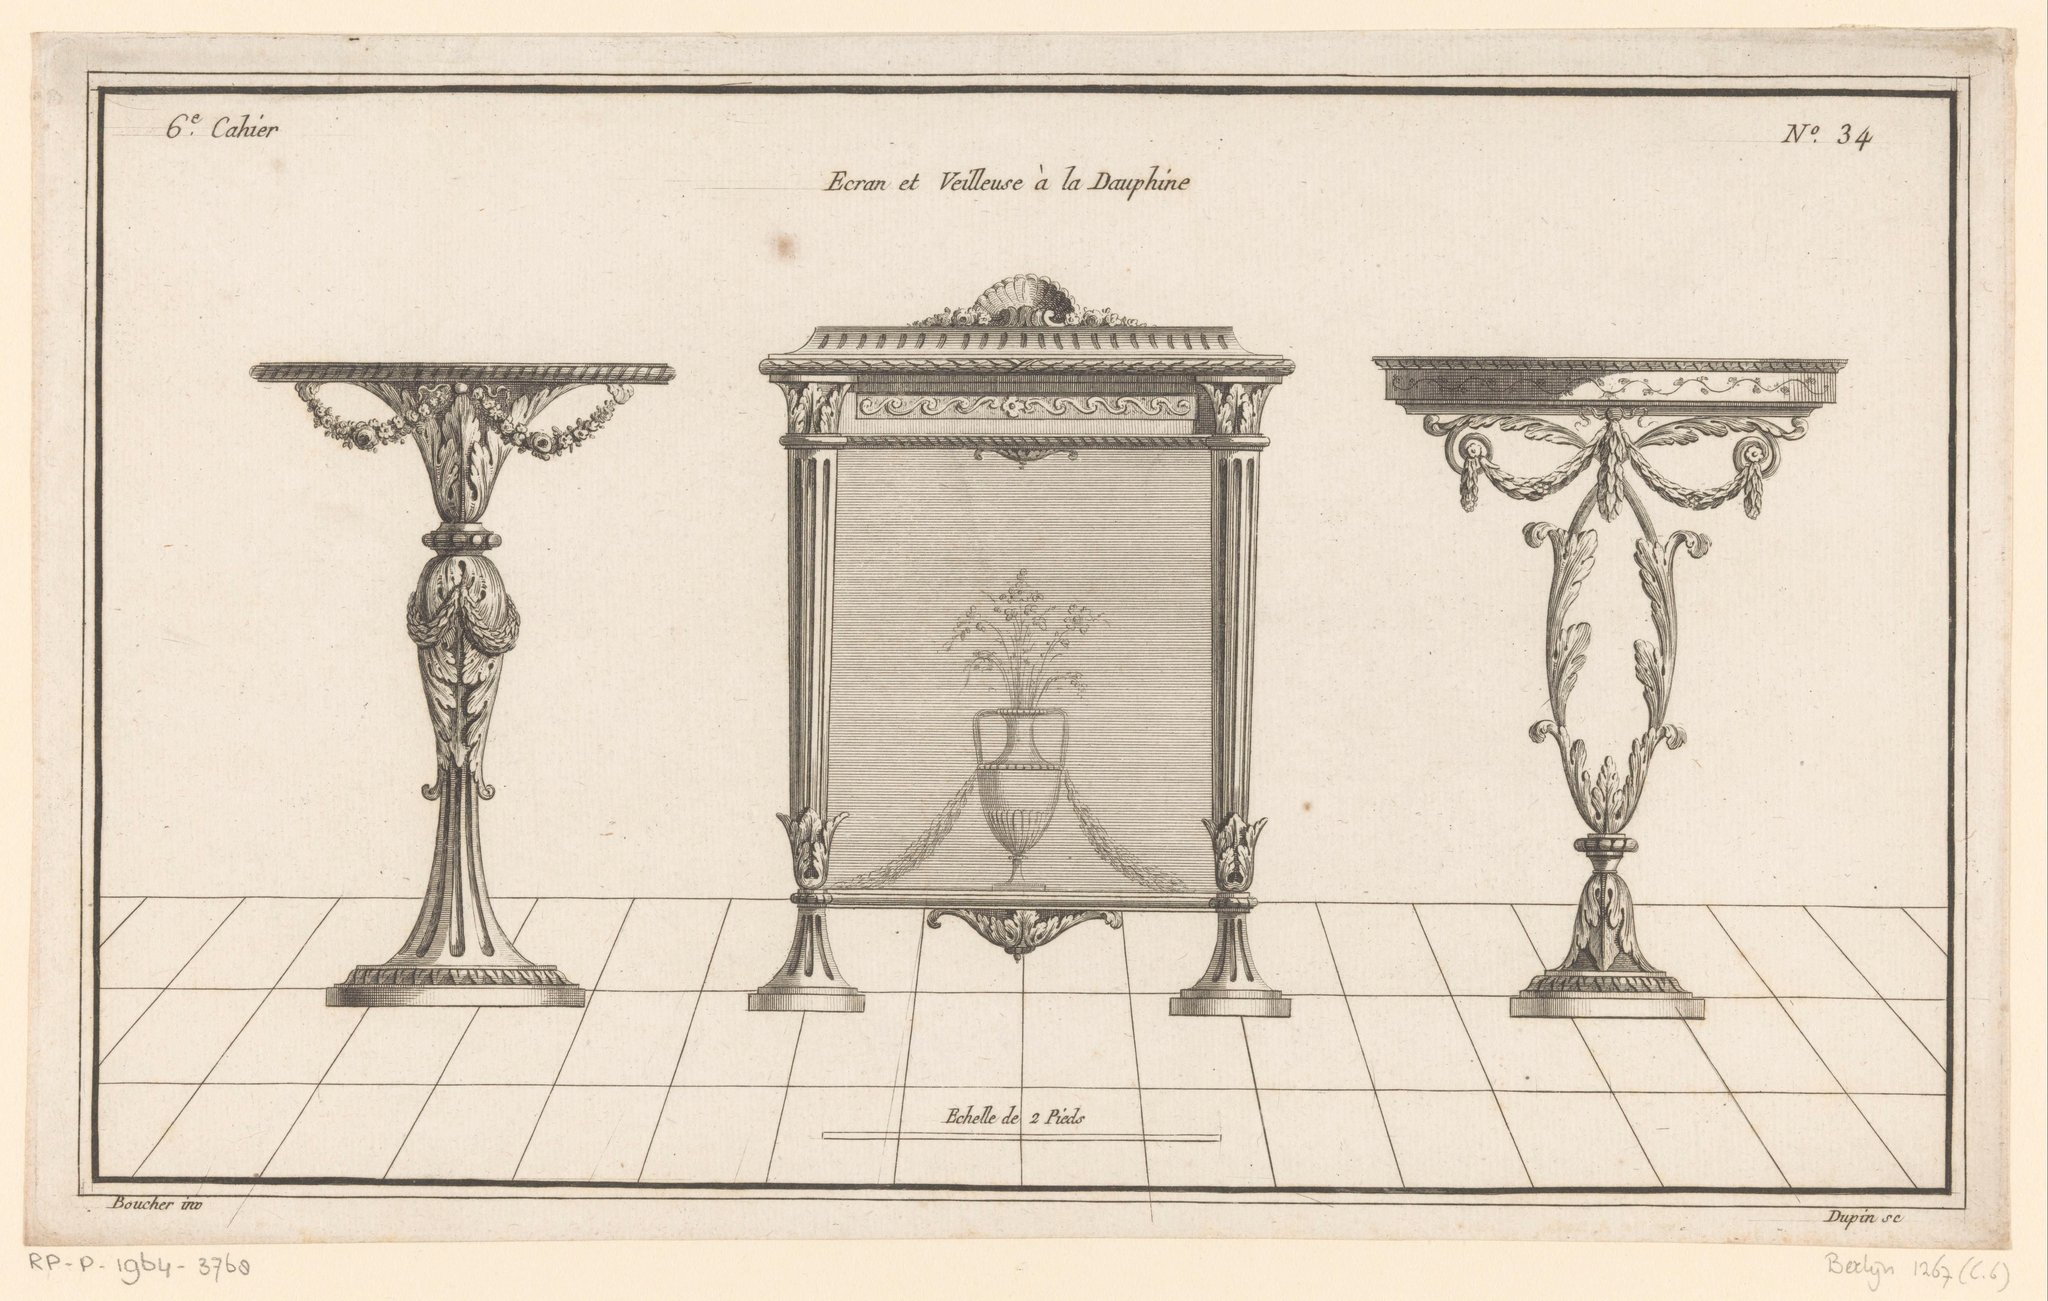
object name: print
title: 6e Cahier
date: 1772-1779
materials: paper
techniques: engraving, etching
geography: paris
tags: fire-screen, table, flowers in a vase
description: Een geornamenteerd haardscherm met een vaas met bloemen en aan weerszijden geornamenteerde bijzettafels met guirlandes. Prentnummer 34.